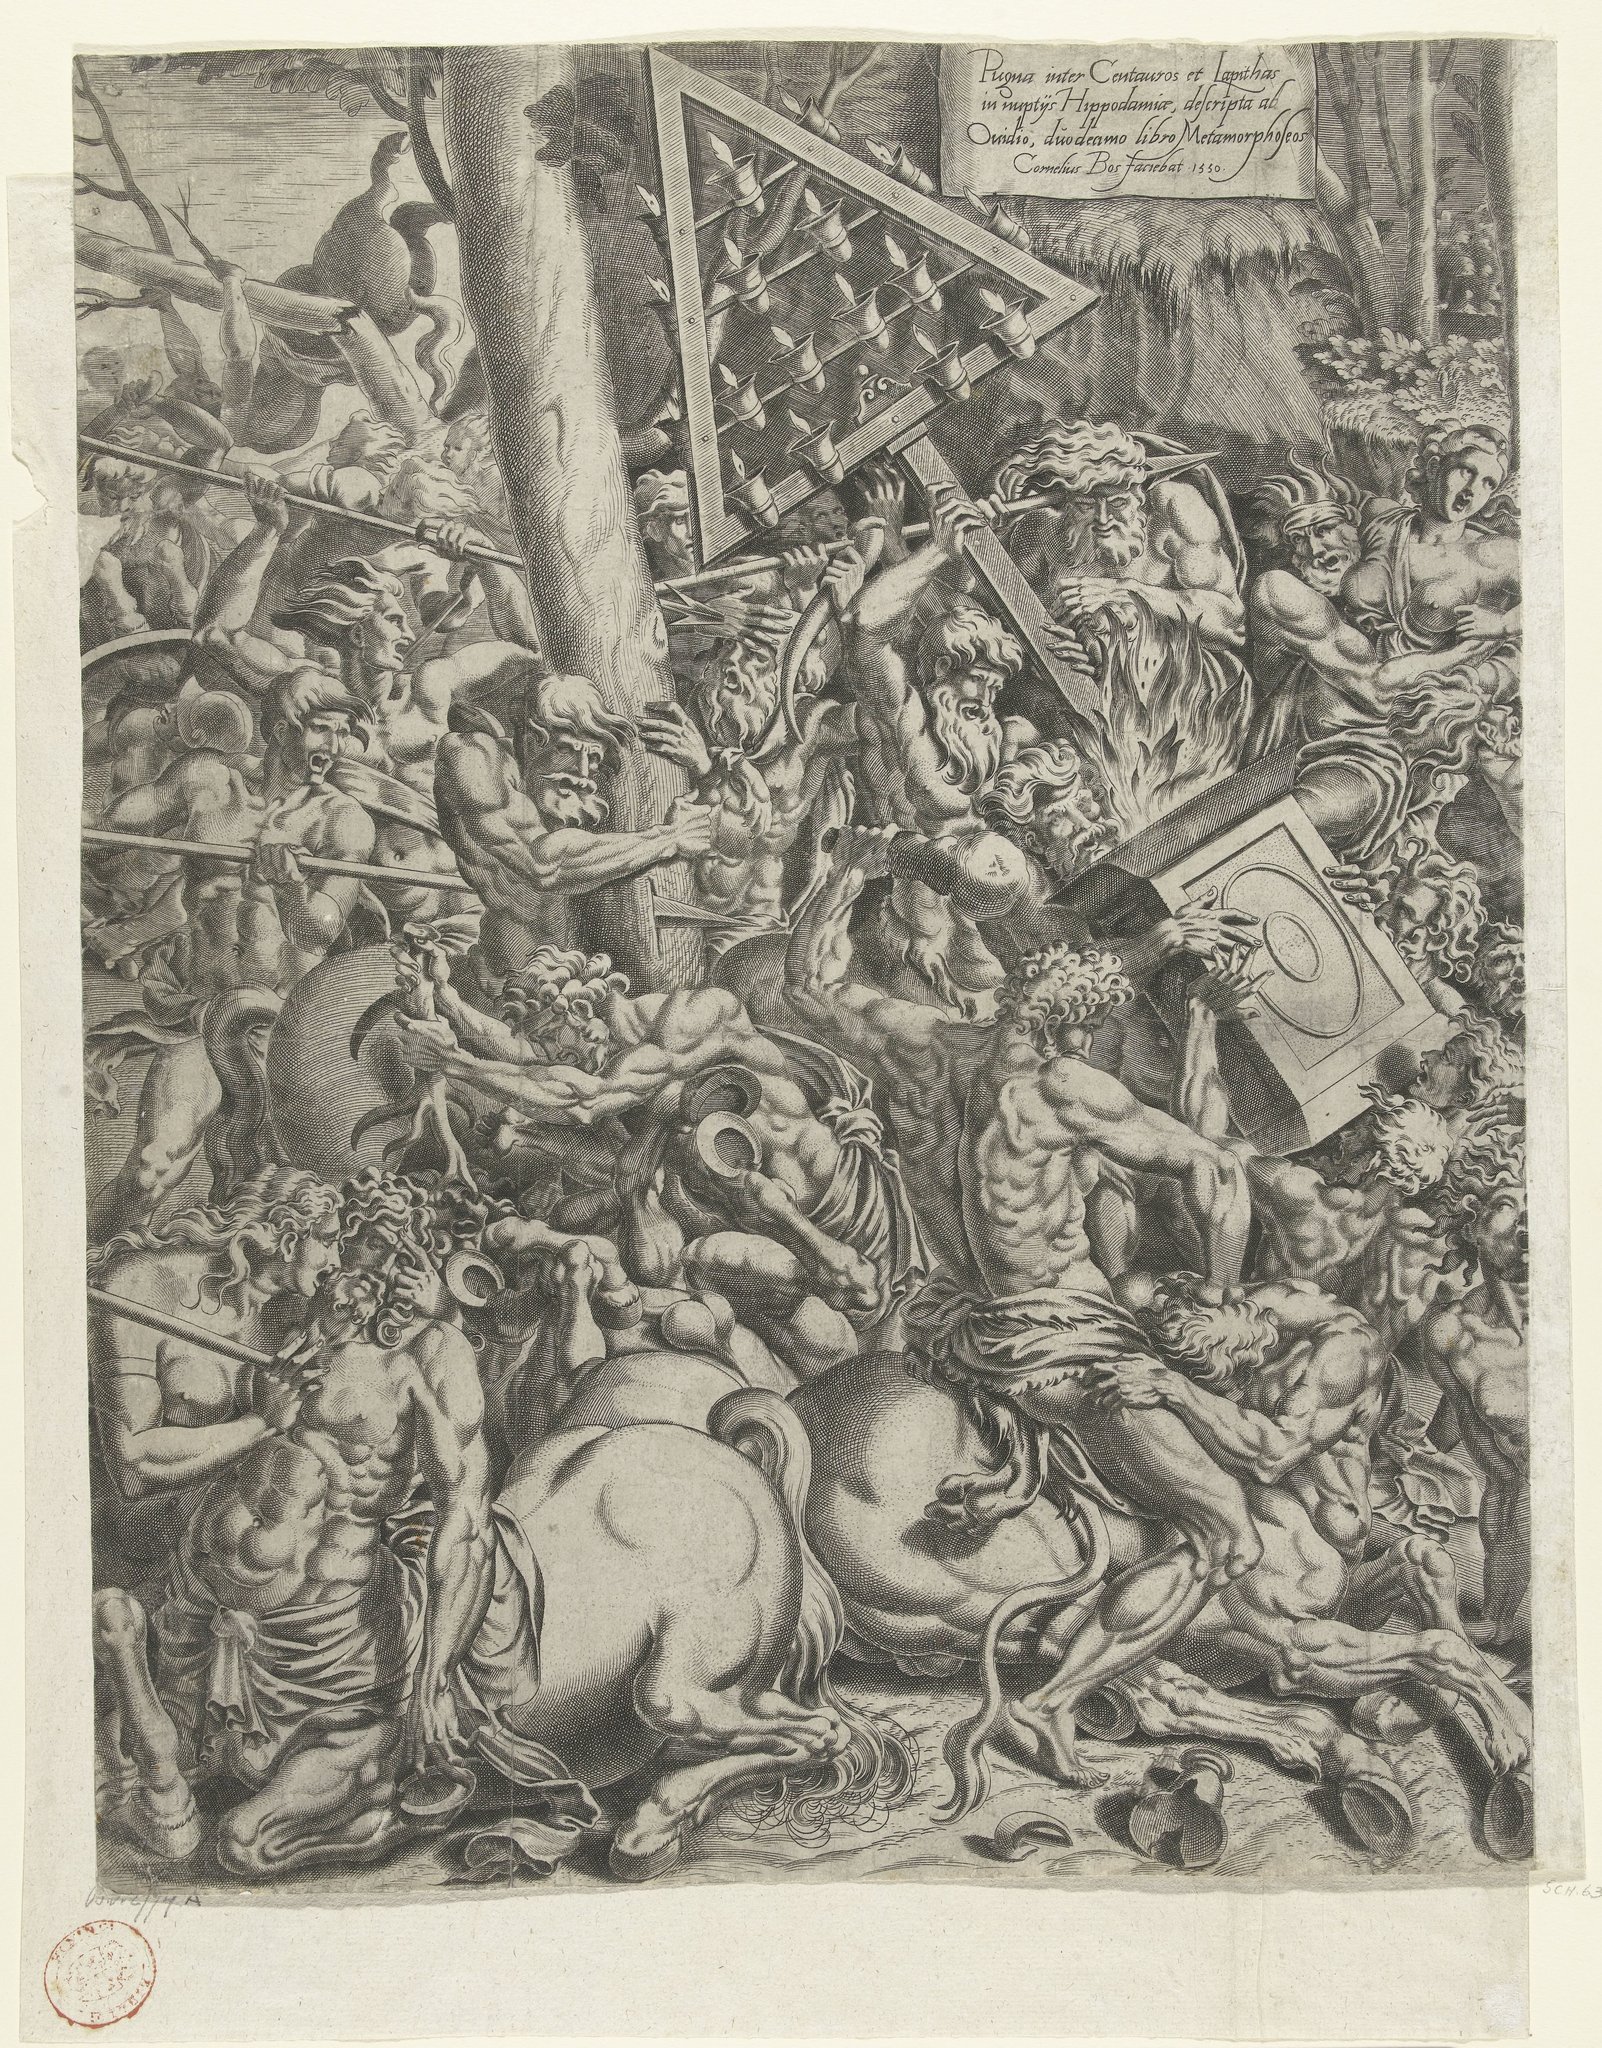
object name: print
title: Pugna inter Centauros et Lapithas in nuptijs Hippodamiæ (...)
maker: cornelis bos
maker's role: print maker, printer, publisher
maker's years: 1510-1566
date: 1550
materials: paper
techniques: engraving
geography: groningen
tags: fight of lapiths and centaurs at the wedding of pirithous and hippodamia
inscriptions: collector's mark: Lugt 2228, collector's mark: Lugt 240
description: Gruwelijke strijd tussen de Centauren en de Lapithen. De Lapithen vieren de bruiloft van hun koning Pirithoüs en Hippodamea. De Centauren die uitgenodigd zijn beginnen een bloedige strijd en proberen de bruid te ontvoeren. Alles wat men in handen kan krijgen wordt als wapen gebruikt. Veel Centauren worden gedood met speren.